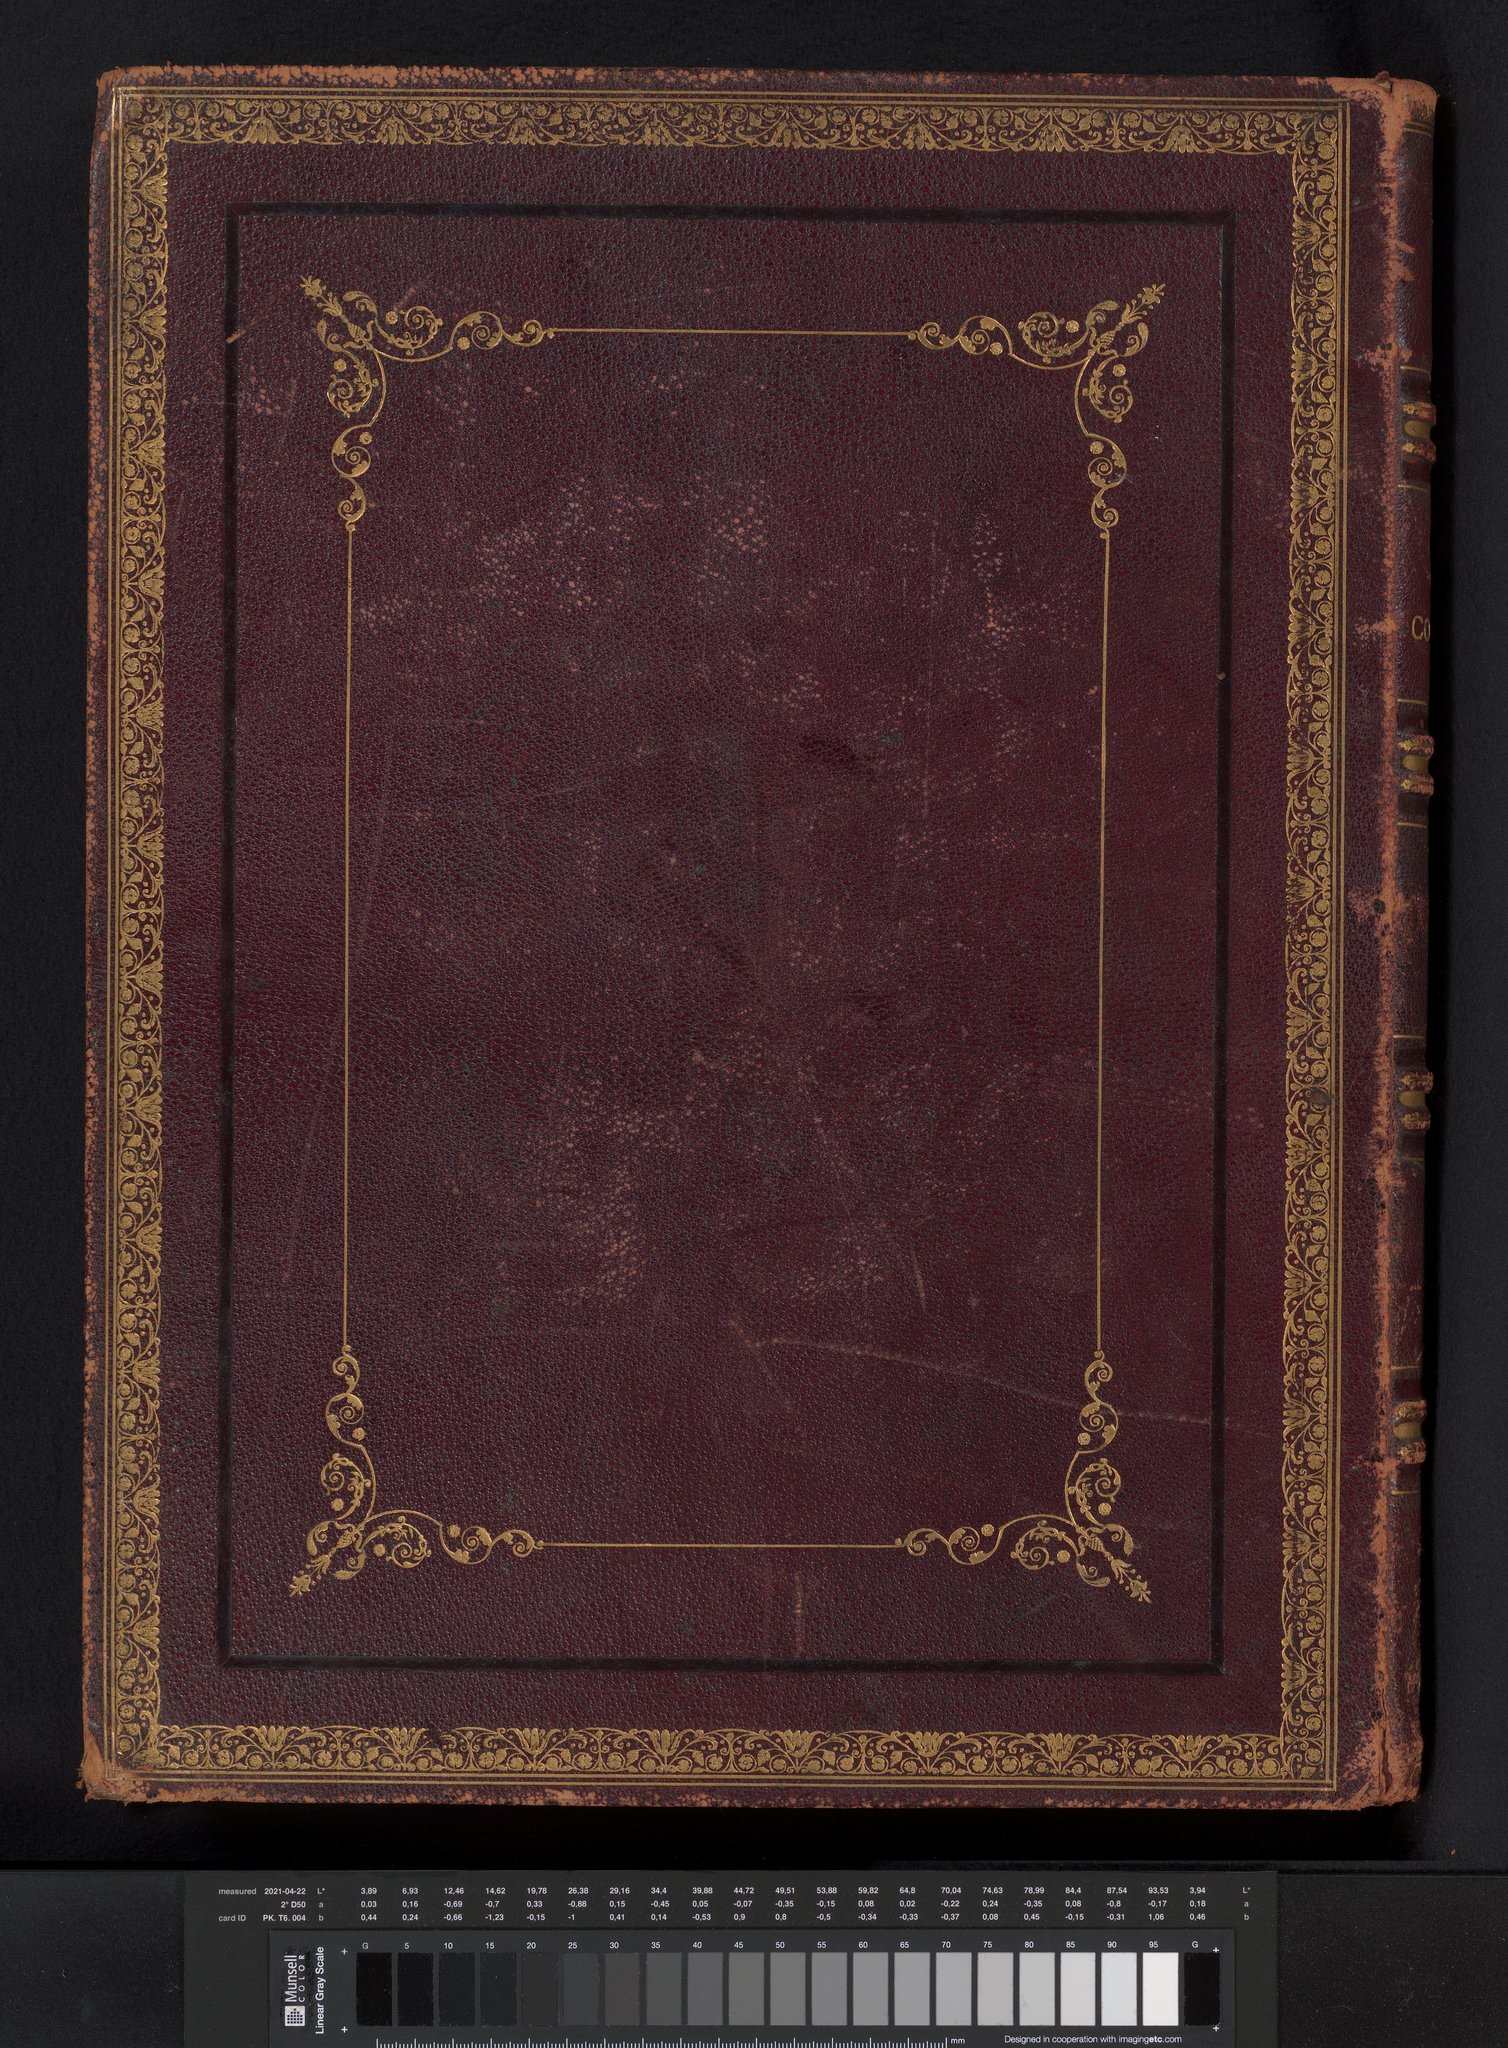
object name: print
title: Joseph Charles Roettiers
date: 1774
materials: paper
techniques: engraving, etching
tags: paris, joseph charles roëttiers, portrait, self-portrait of sculptor, historical persons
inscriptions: date